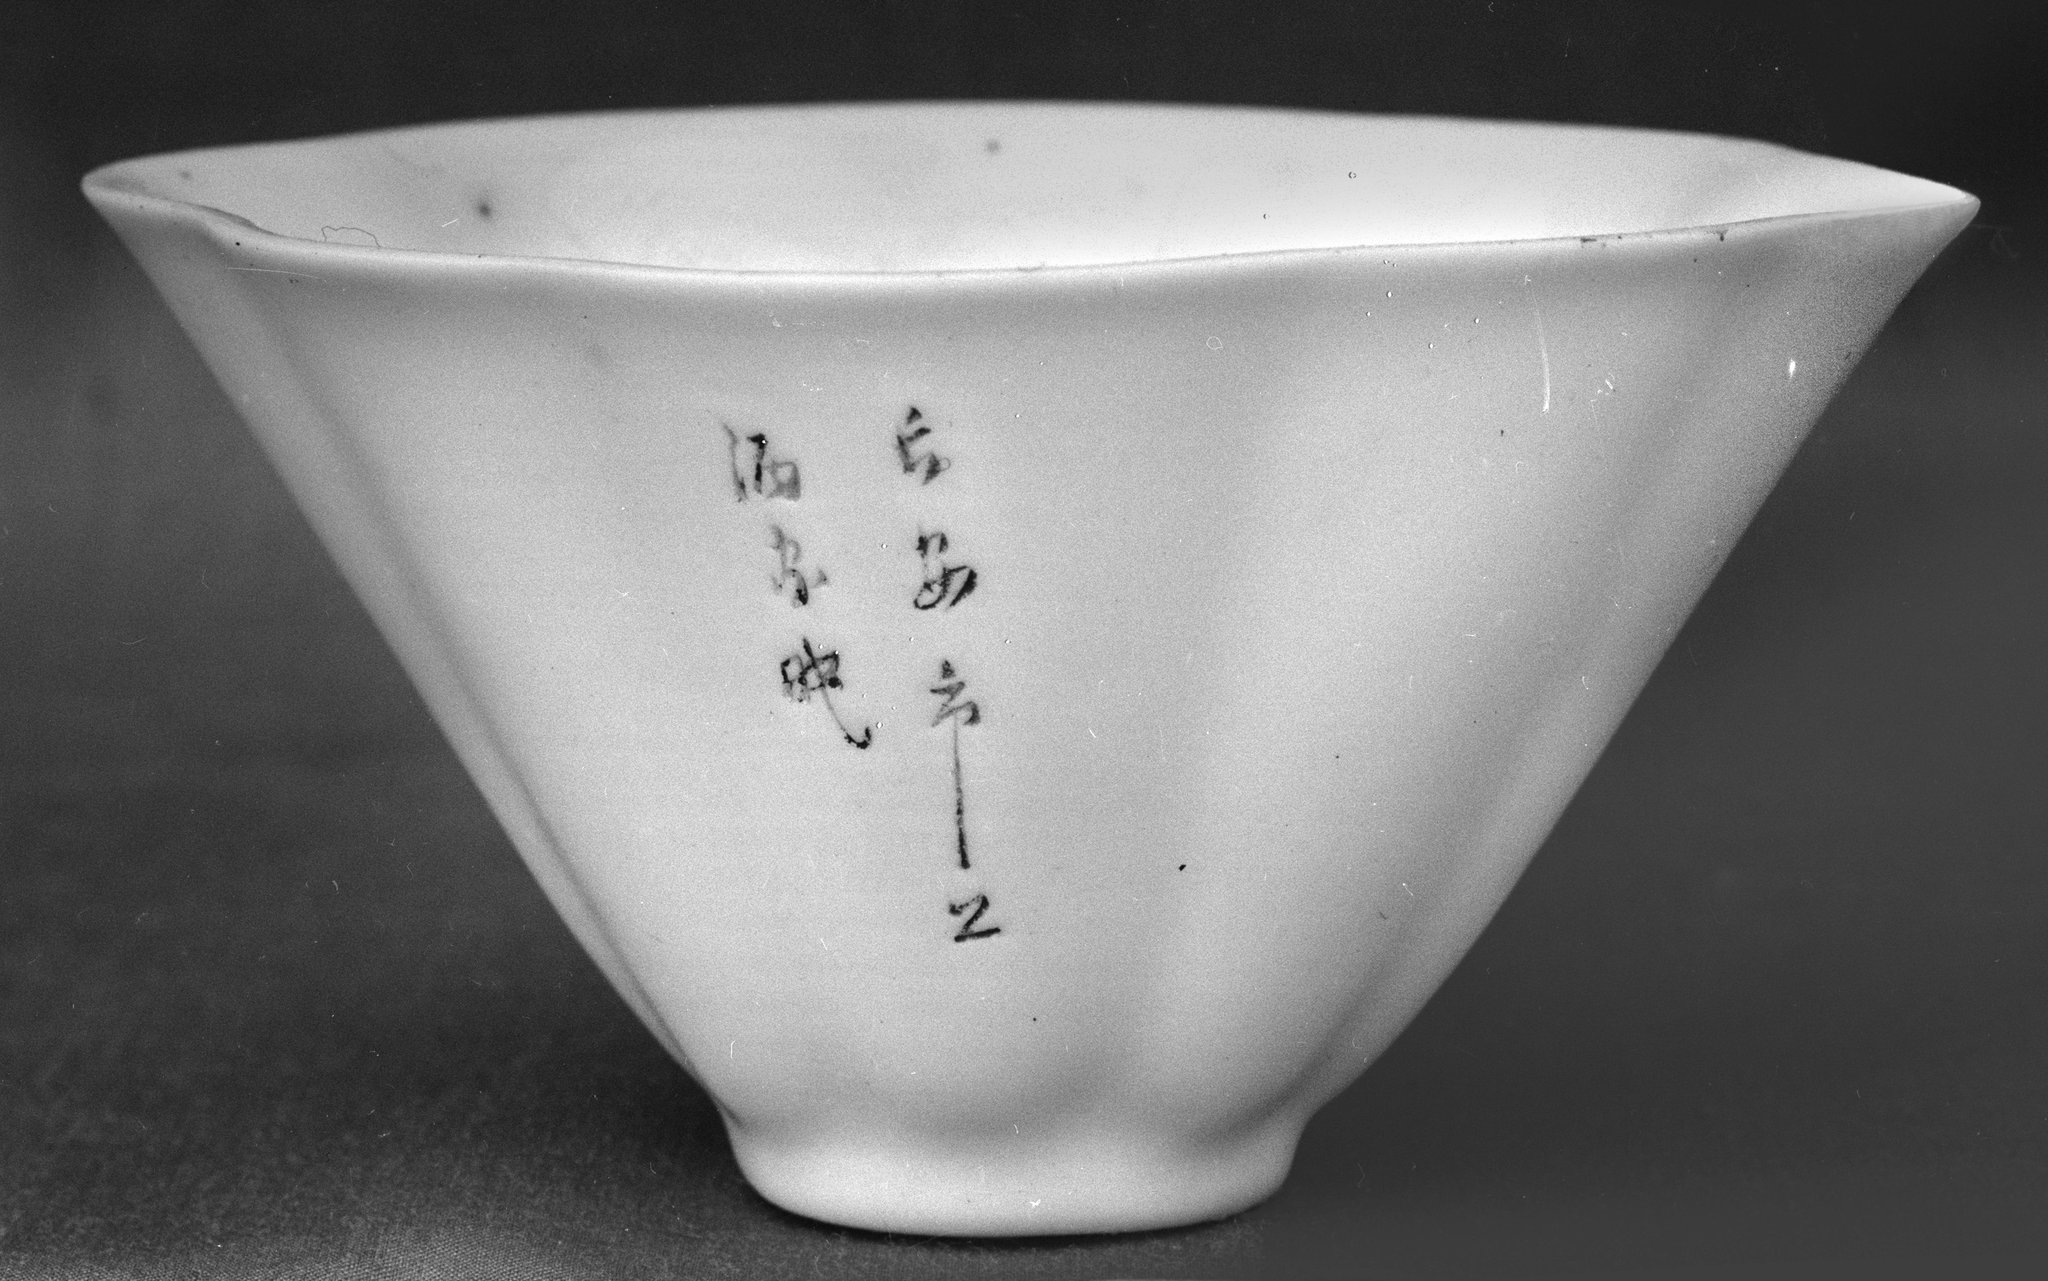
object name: cup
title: Cup with poem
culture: chinese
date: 1667-1733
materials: porcelain